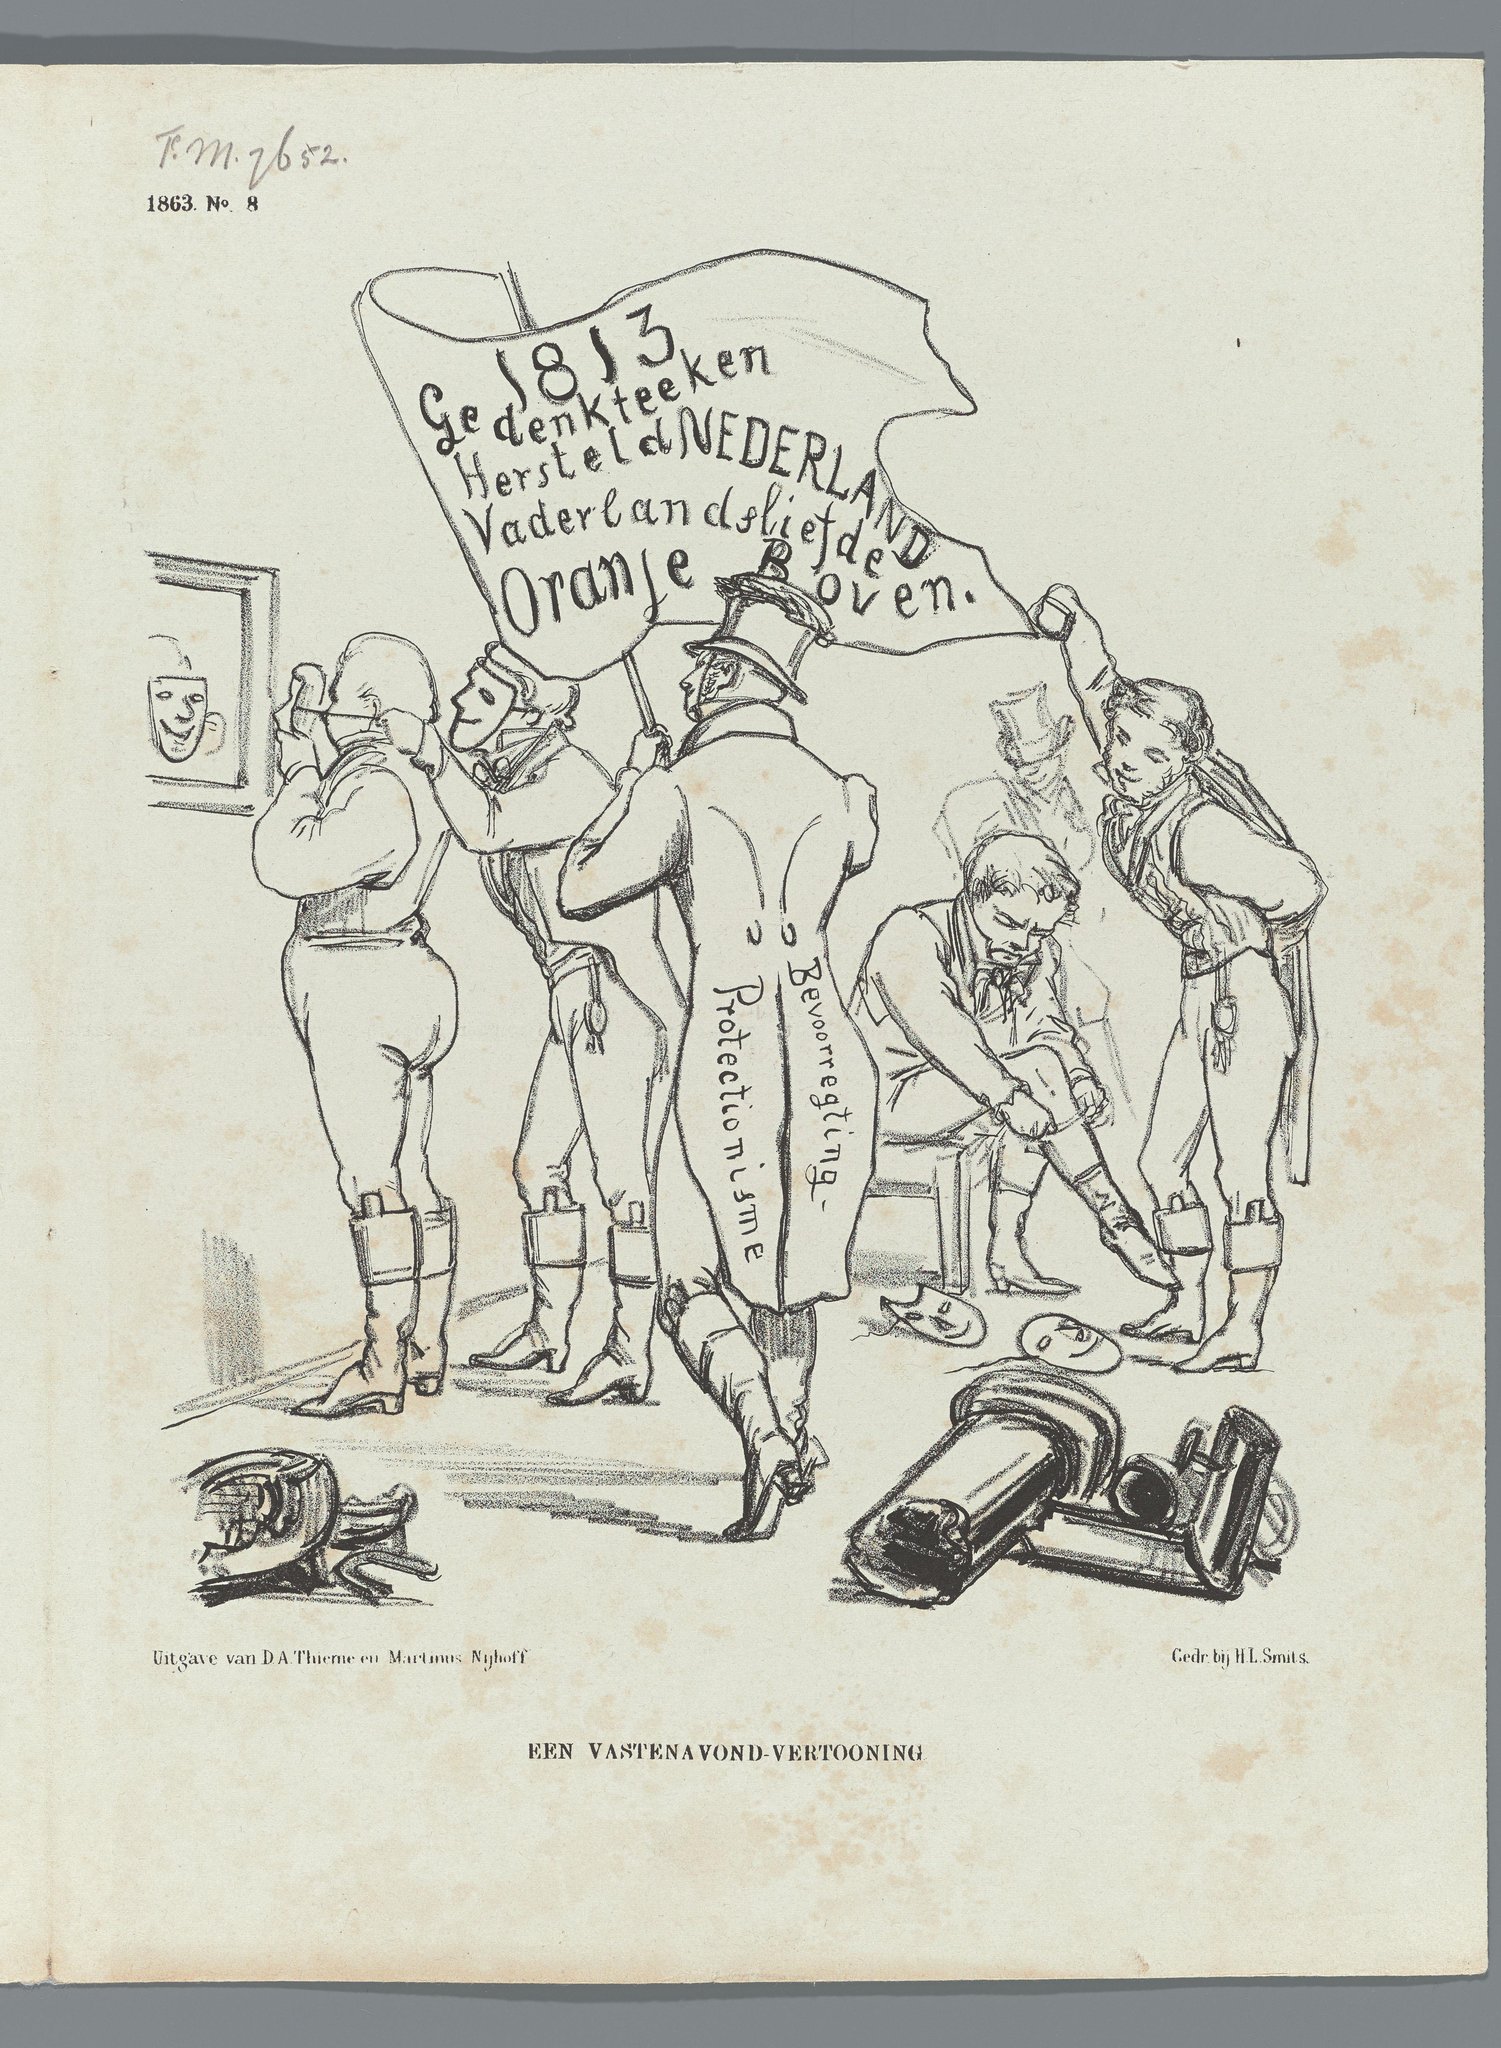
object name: print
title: Een Vastenavond-vertooning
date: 1863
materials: paper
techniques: lithograph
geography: arnhem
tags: mask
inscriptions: collector's mark: Lugt 2228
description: Spotprent op de protectionisten (Regout c.s.) die zich van de leiding van de aanstaande novemberfeesten rond het vijftigjarige jubileum van het herstel van de vrijheid in Nederland meester wilden maken. Een groep mannen doet maskers voor en verkleedt zich. Plaat verschenen bij het weekblad De Nederlandsche Spectator, nr. 8, 21 februari 1863.